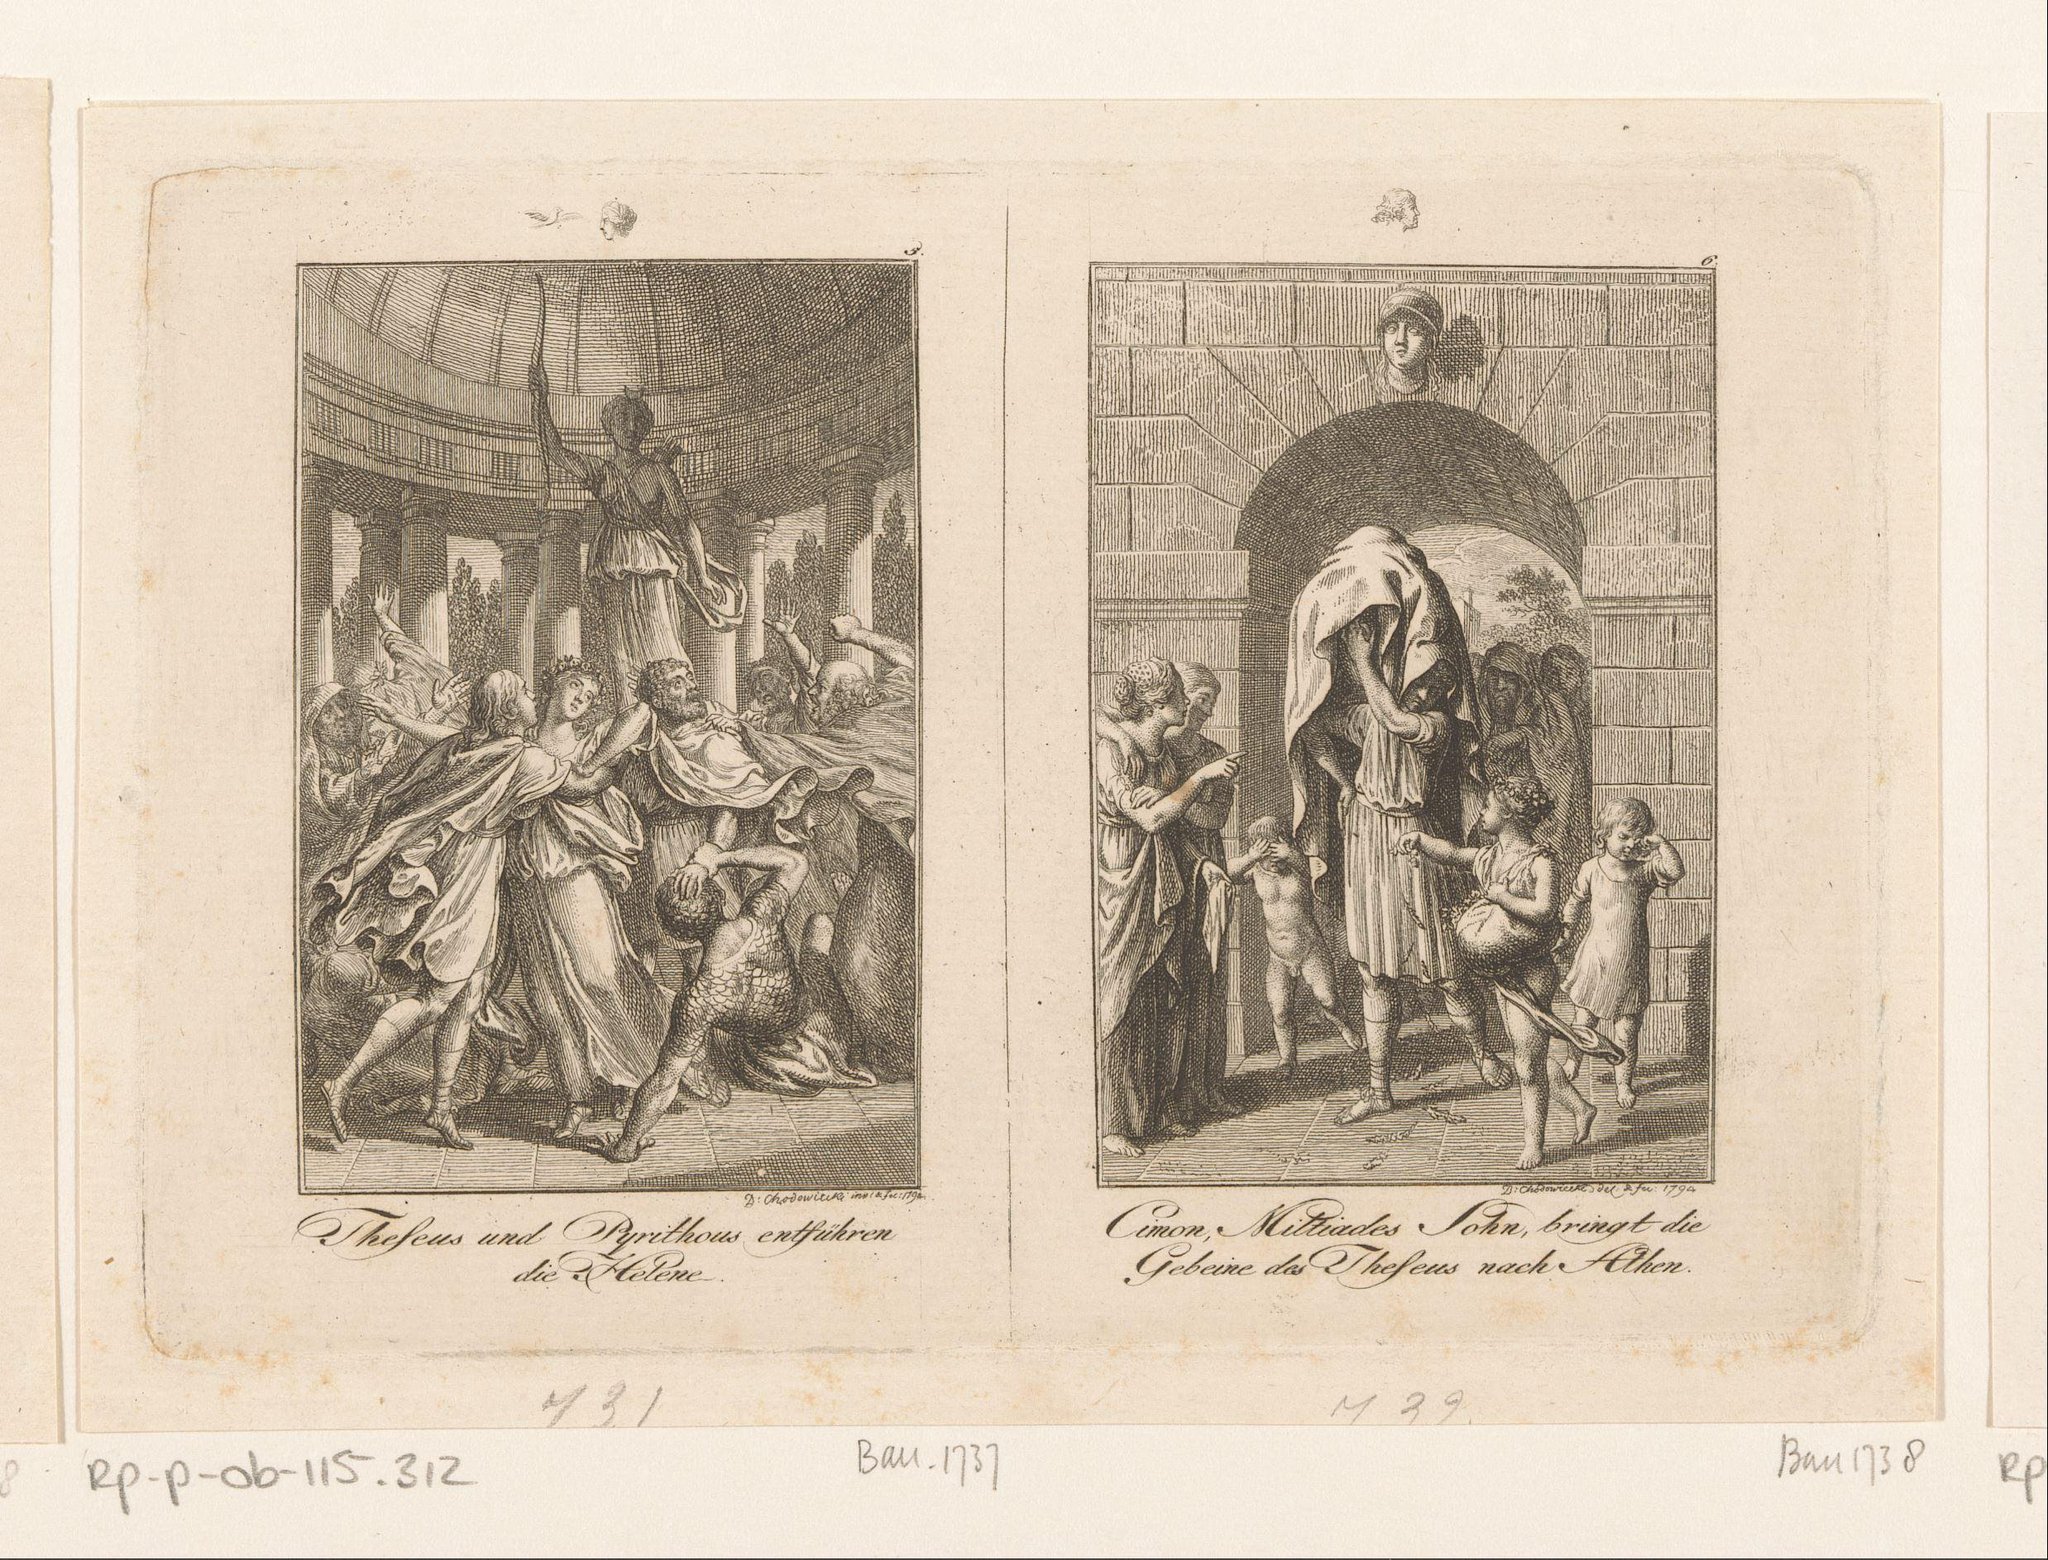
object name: print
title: Twee voorstellingen uit het leven van Theseus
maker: daniel nikolaus chodowiecki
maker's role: draughtsman, print maker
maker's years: 1726-1801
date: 1794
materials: paper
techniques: etching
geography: berlin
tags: theseus and pirithous abducting helen, cimon, the athenian, brings theseus' bones back to his city, (story of) theseus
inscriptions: collector's mark: Lugt 2228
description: Links: De ontvoering van Helena. Rechts: Kimon draagt de botten van Theseus Athene binnen. Met onderschrift in het Duits en linksboven genummerd: 5,6. In de marge zijn op schetsmatige wijze verschillende koppen geëtst.